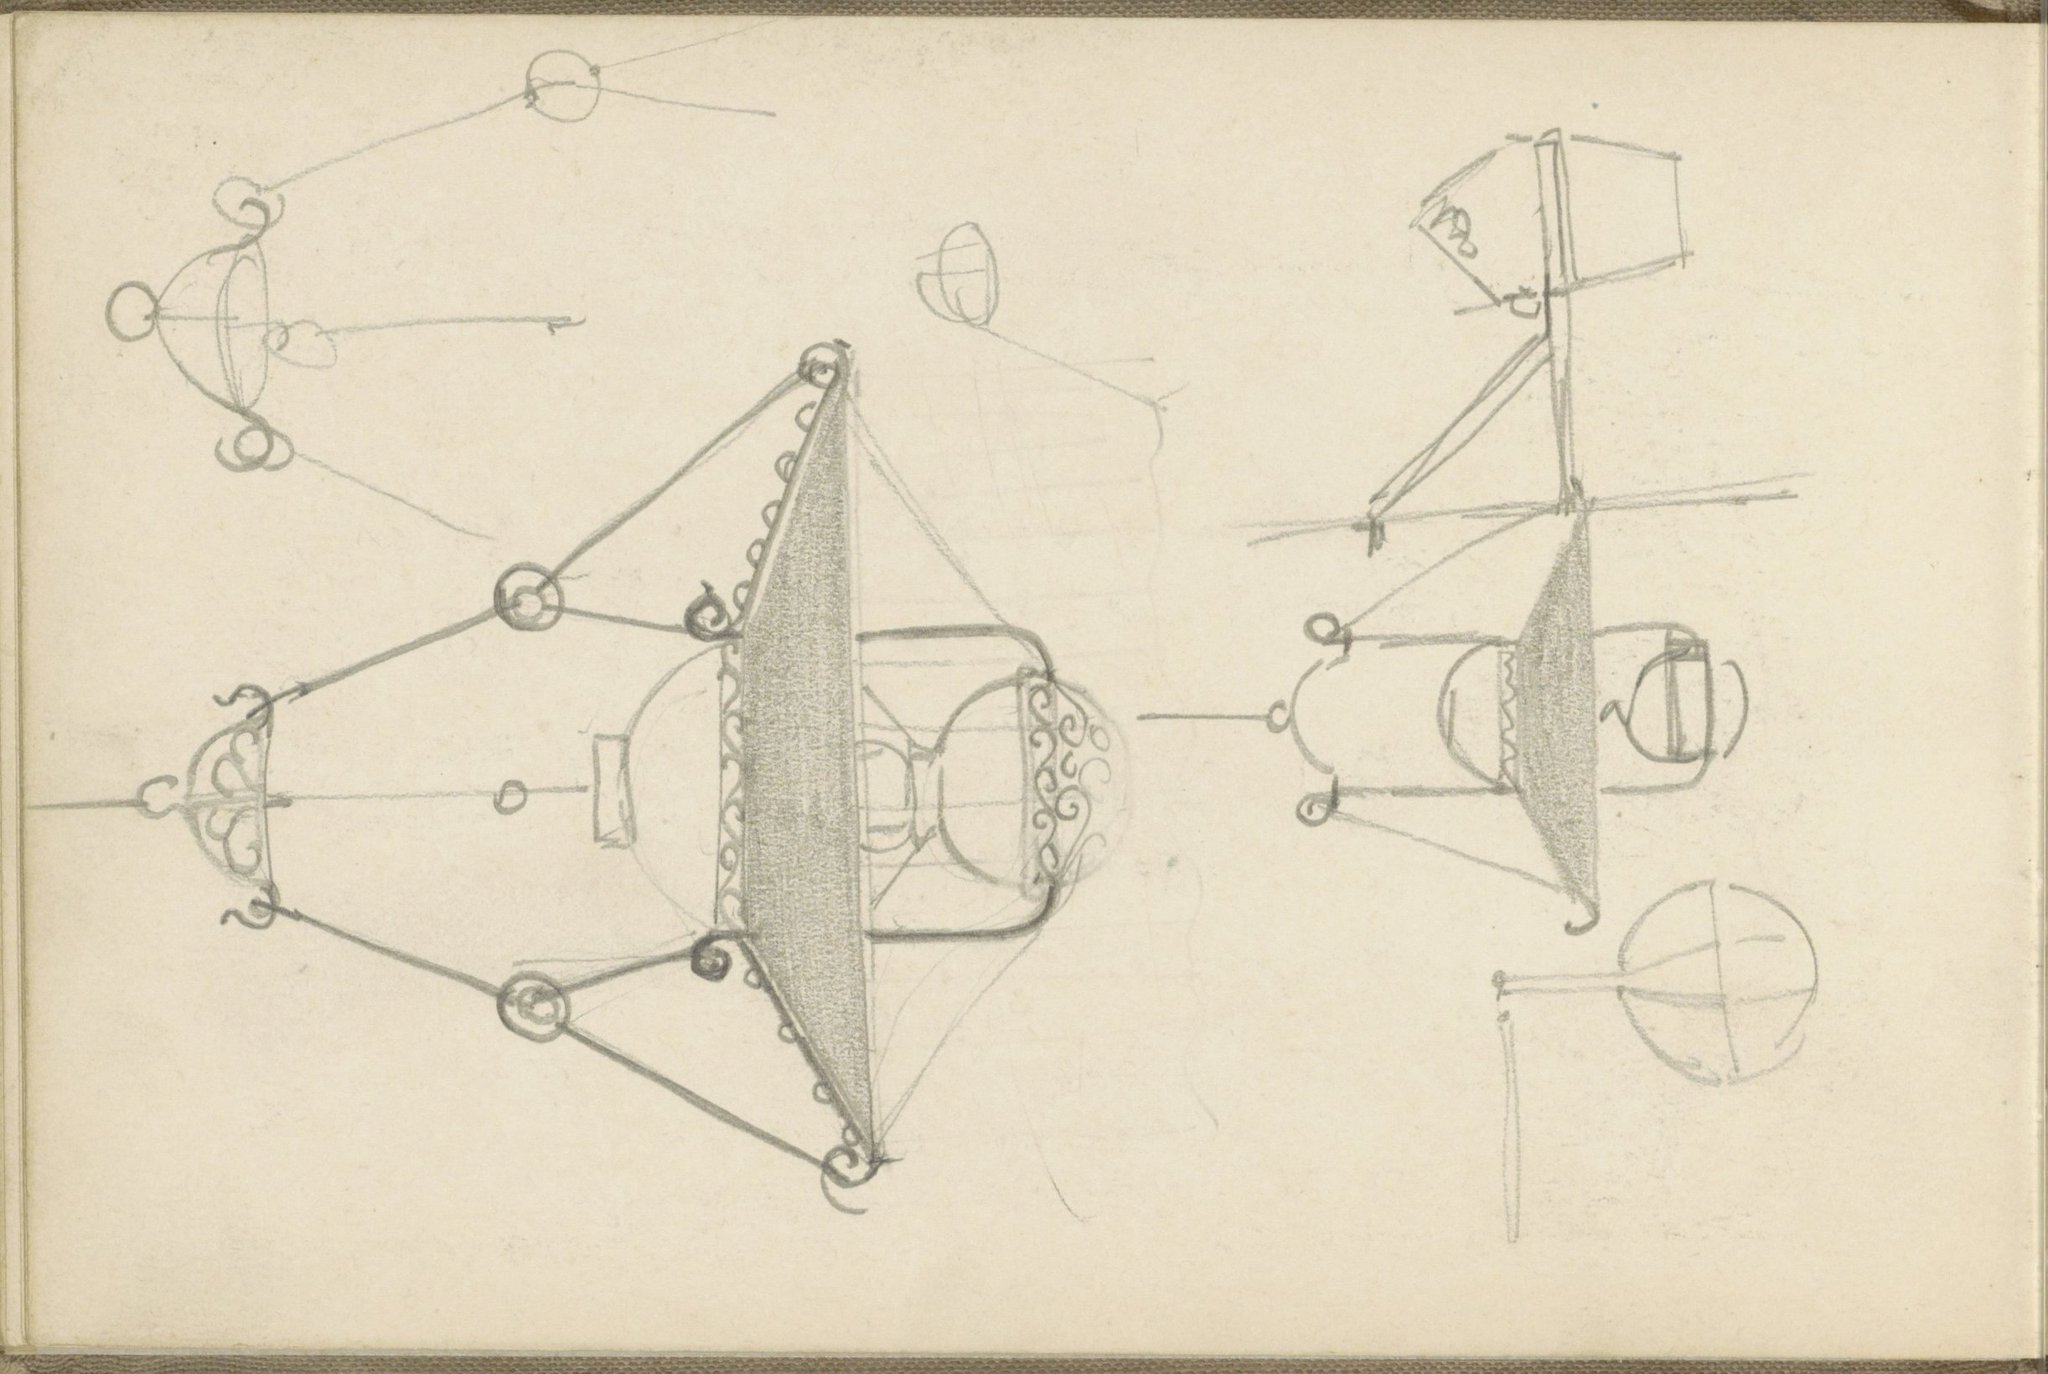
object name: sketchbook leaf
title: Ontwerpen voor elektrische hanglampen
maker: carel adolph lion cachet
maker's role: draughtsman, print maker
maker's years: 1864-1945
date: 1905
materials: paper, pencil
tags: electric lamp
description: Blad 12 verso uit een schetsboek met 27 bladen.